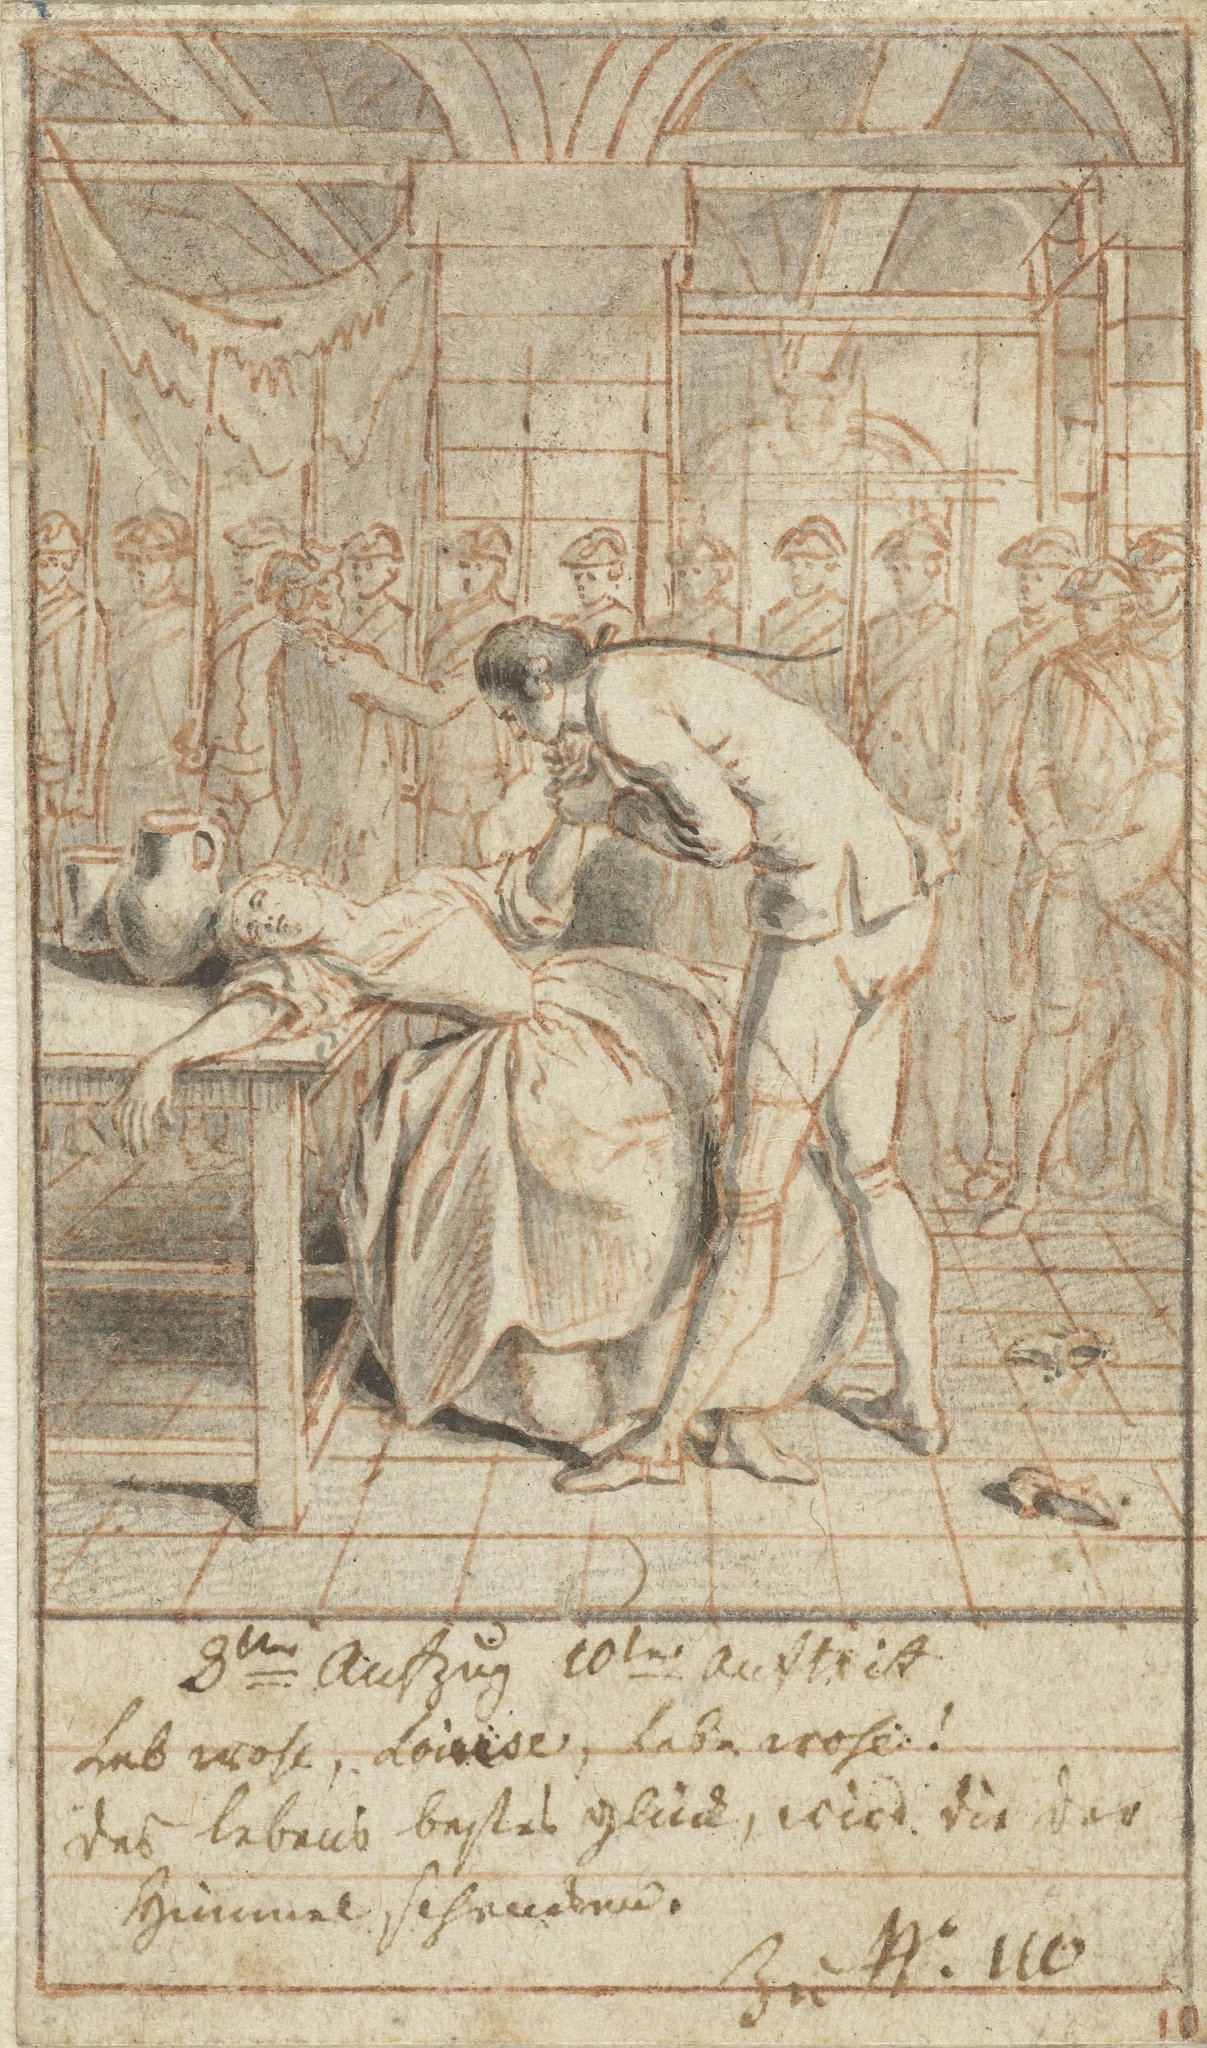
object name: drawing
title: Alexis buigt zich over de flauwgevallen Louise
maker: daniel nikolaus chodowiecki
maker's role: draughtsman, print maker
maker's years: 1726-1801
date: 1770-1775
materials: ink, paper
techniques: brush, pen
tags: specific works of literature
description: Illustratie voor 'Le Deserteur' van Jean-Michel Sedaine.